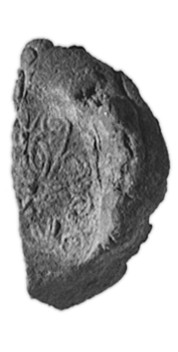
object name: sealing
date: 2030-1640 BCE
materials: clay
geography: egypt